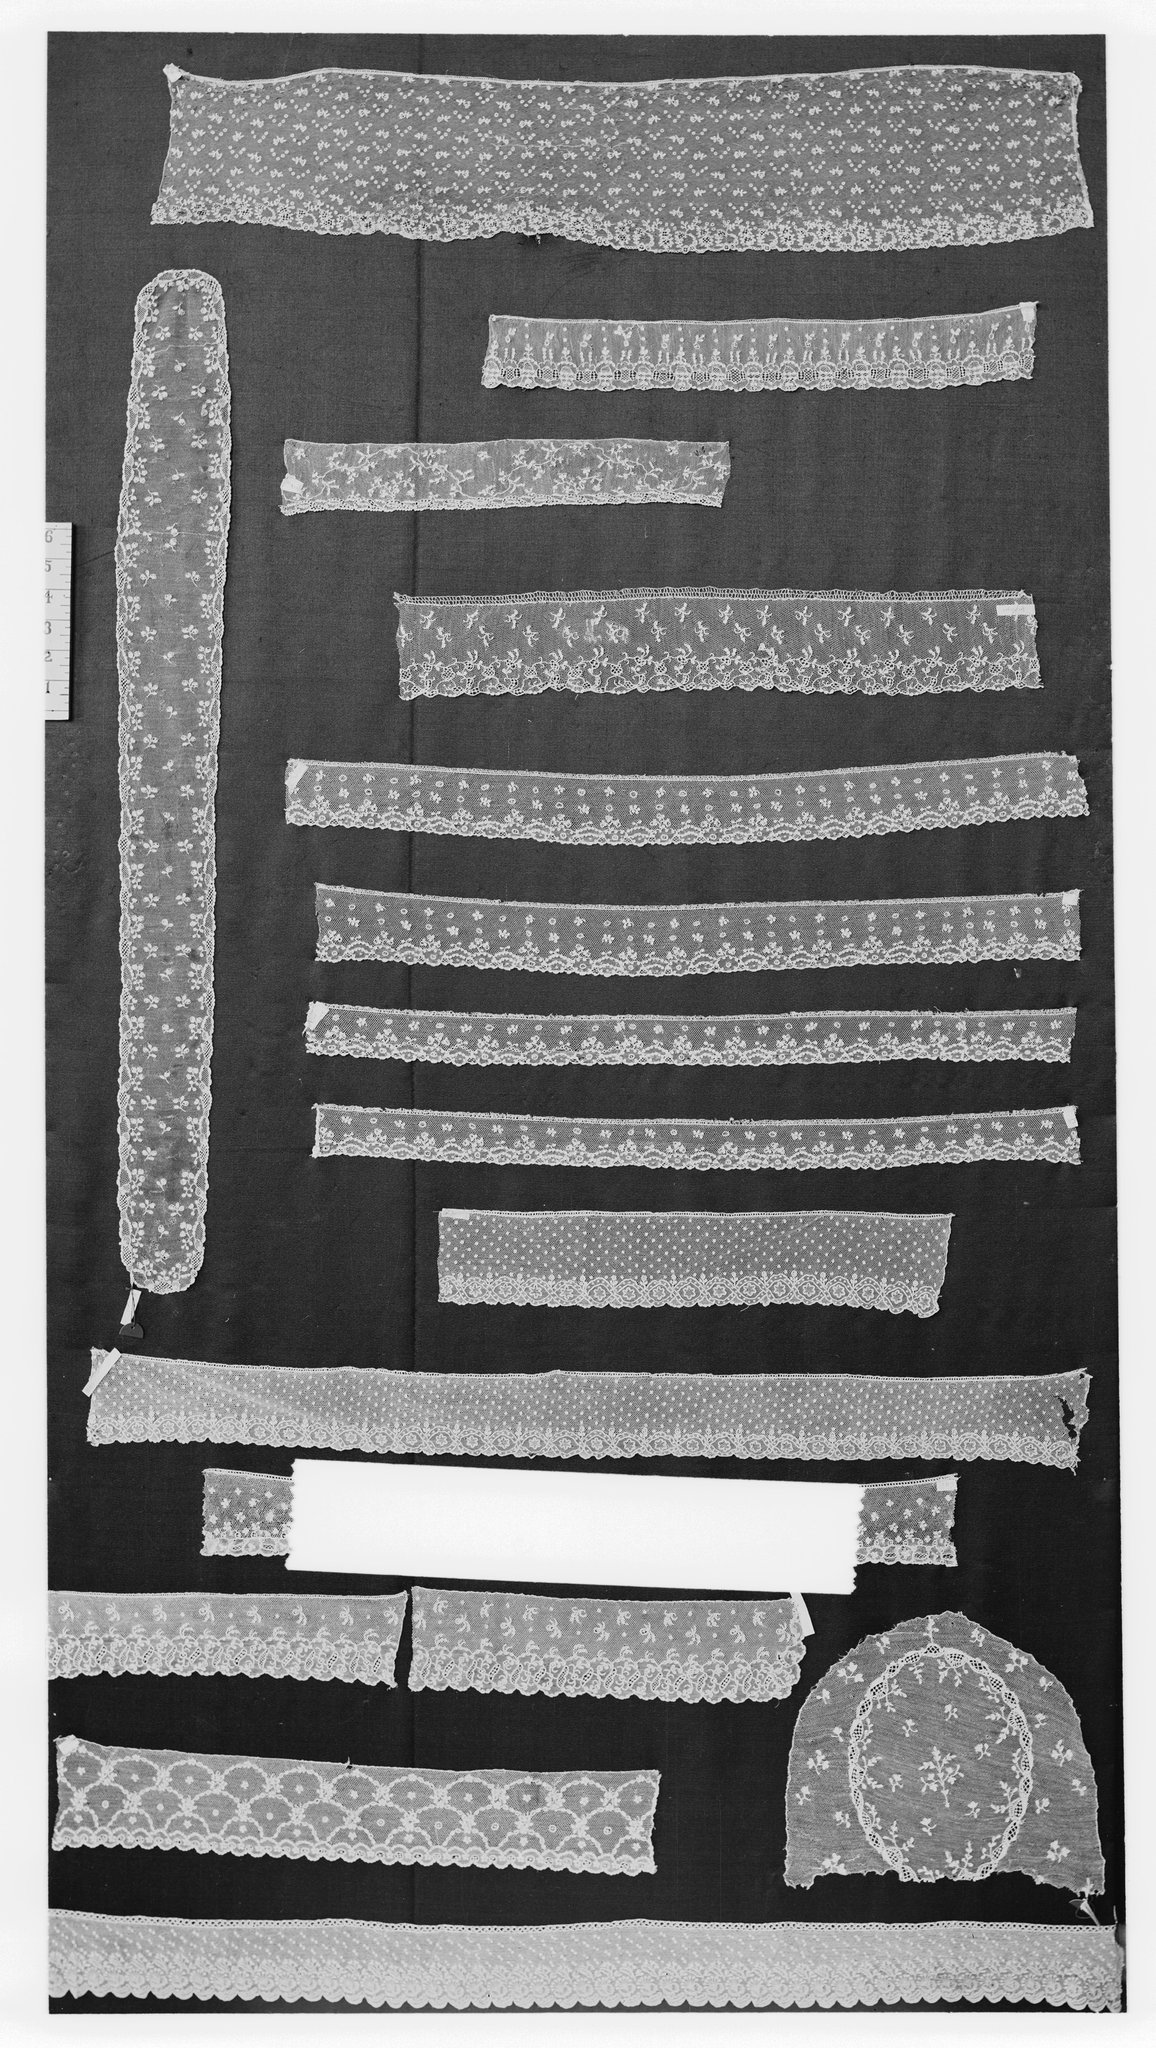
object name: cap crown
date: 1701-1733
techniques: lace